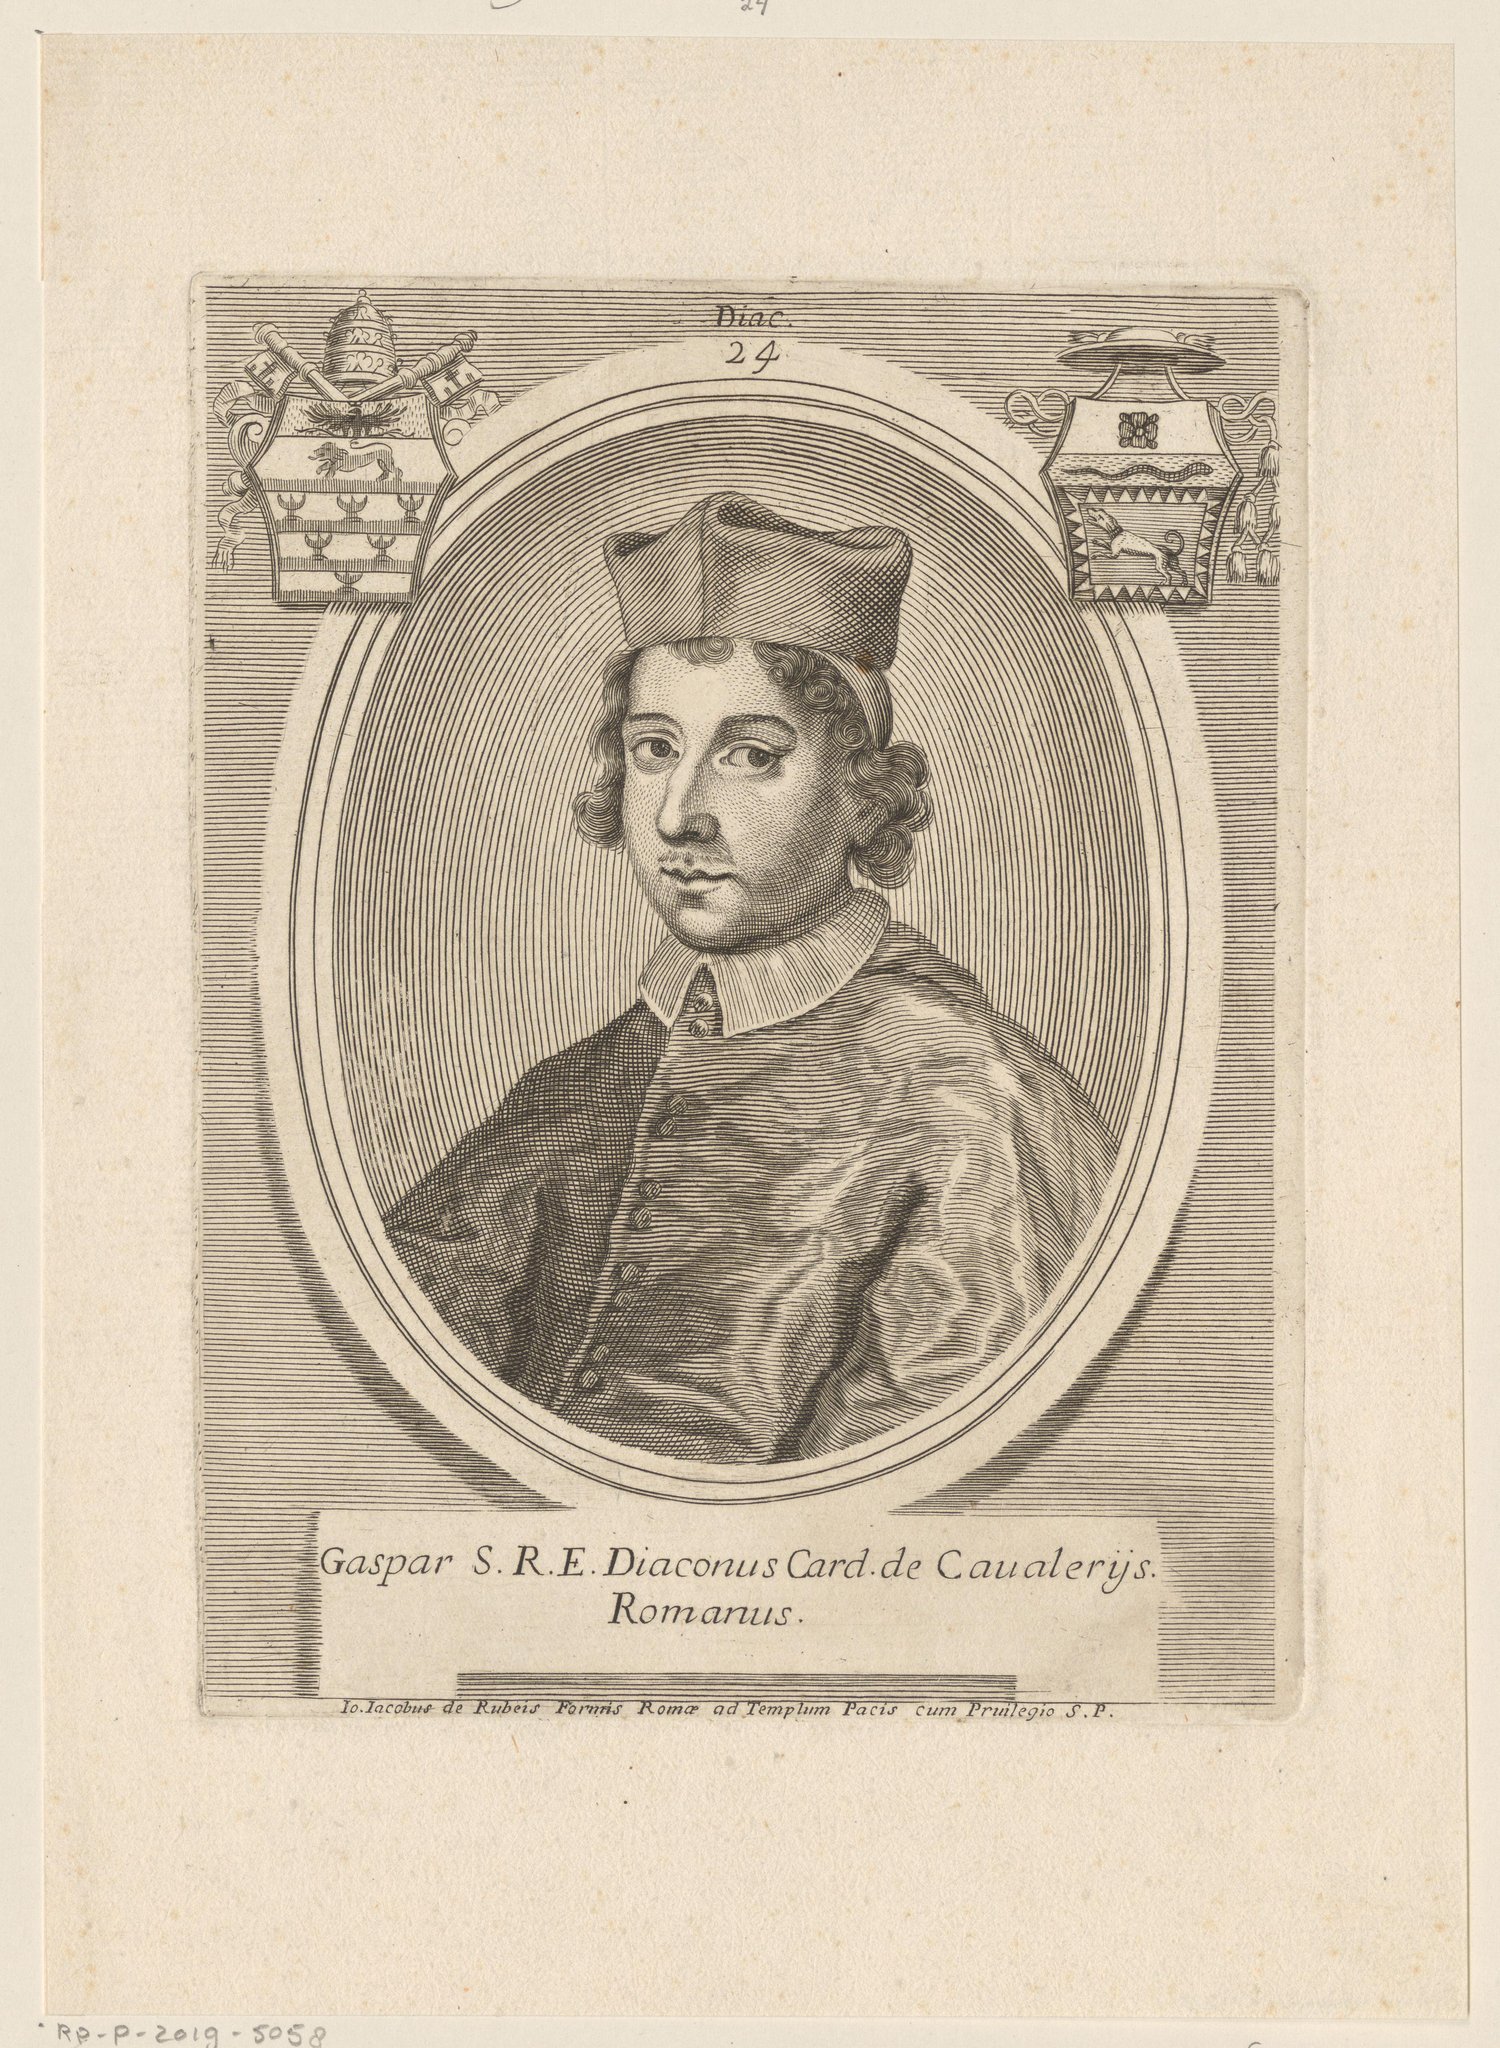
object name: print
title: Portret van kardinaal Gasparo Cavalieri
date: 1686-1691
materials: paper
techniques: engraving, etching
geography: rome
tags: rome, cardinal, historical persons, armorial bearing, heraldry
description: Met rechtsboven zijn wapenschild en linksboven het wapen van paus Innocentius XI.